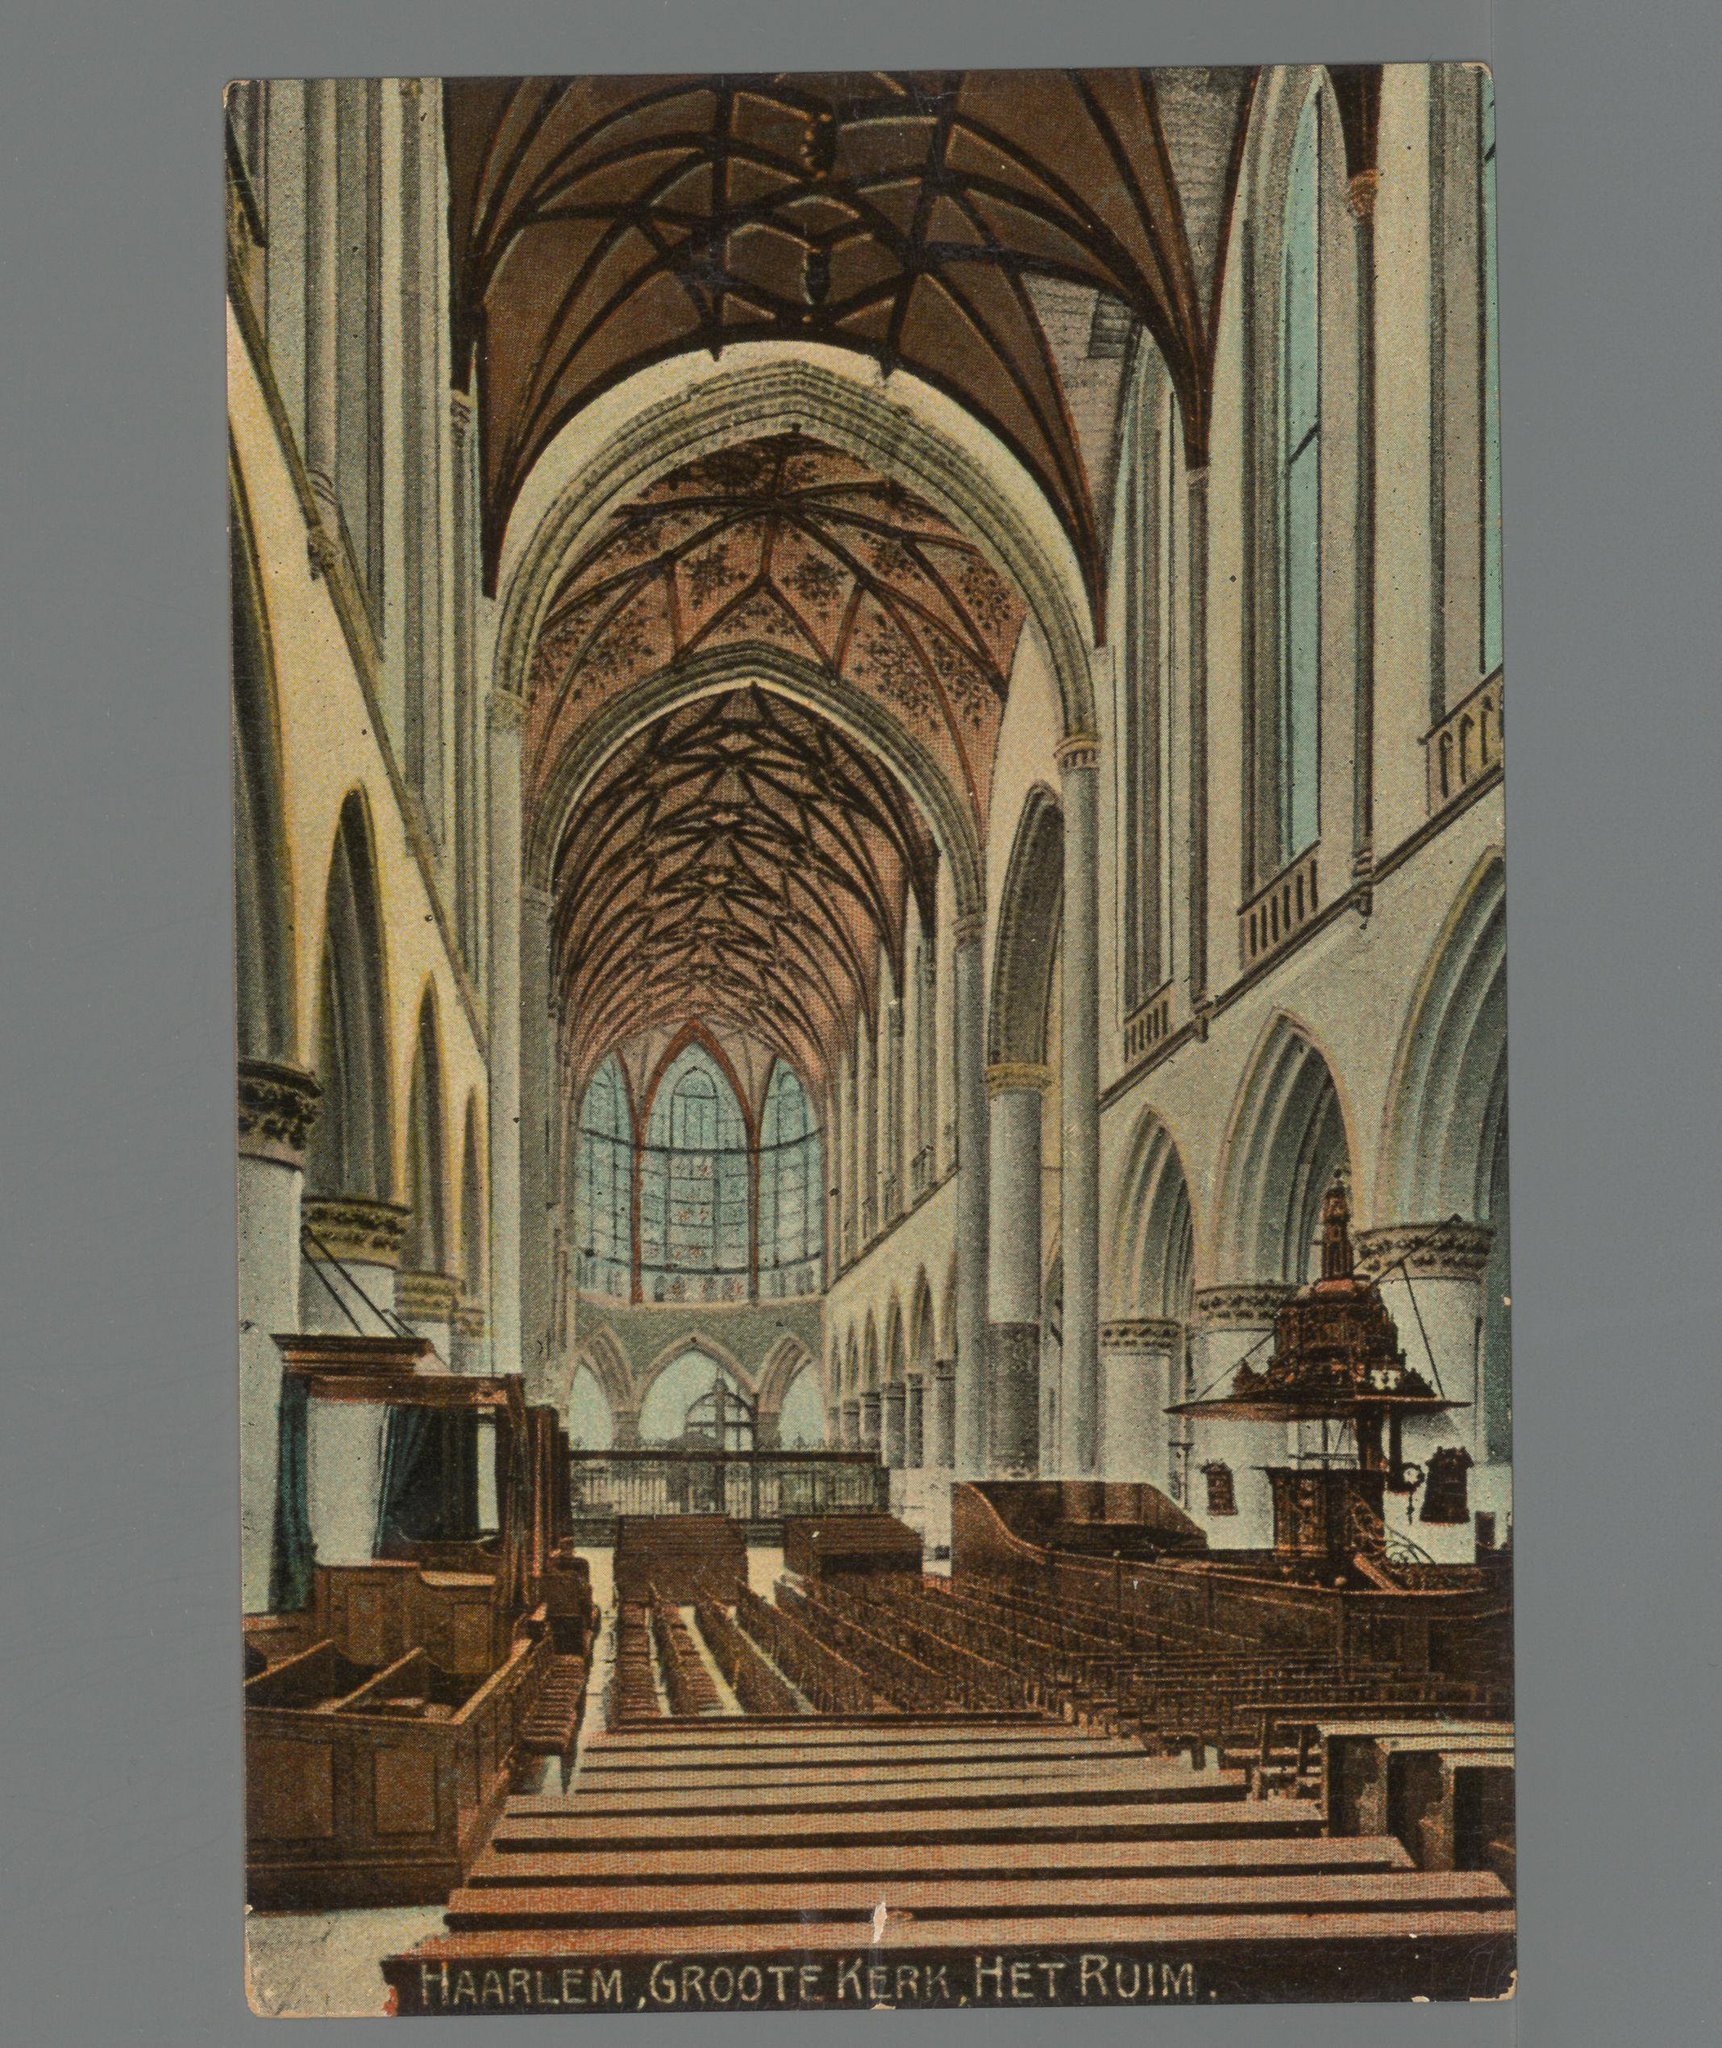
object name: ansichtkaart, prentbriefkaart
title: Schaefers Kunst-Chromo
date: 1905-1906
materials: cardboard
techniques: lithograph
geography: haarlem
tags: interior of church, pulpit, ambo, chancel, haarlem